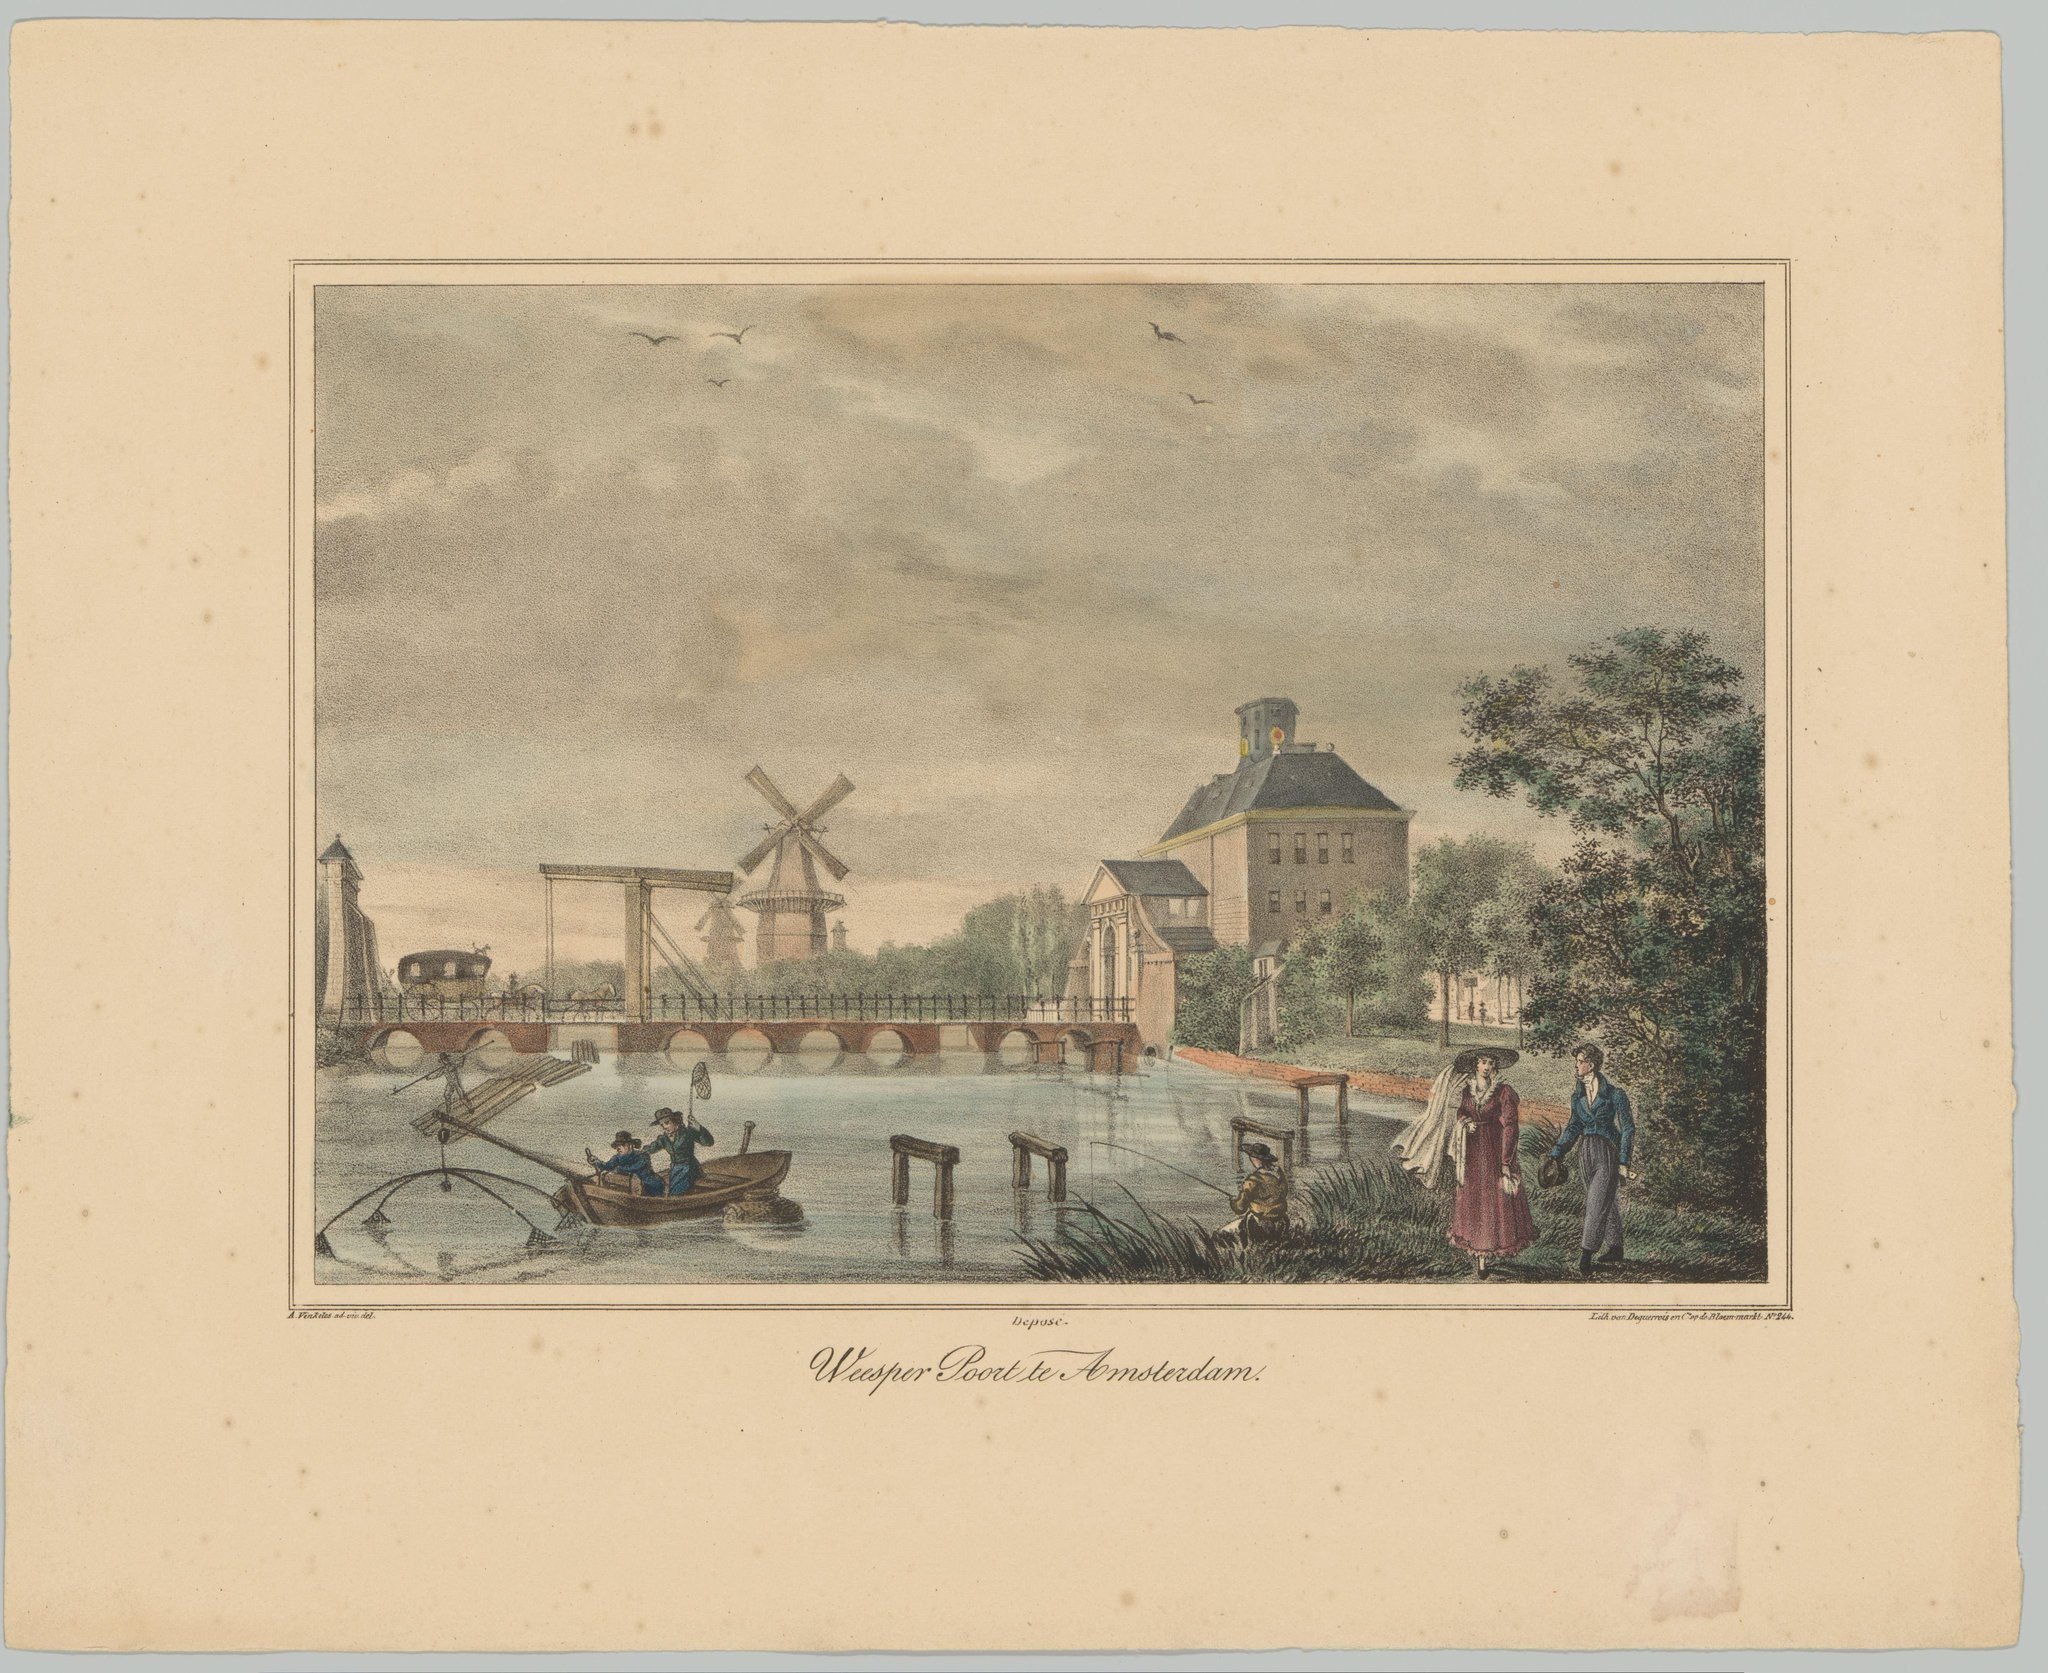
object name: print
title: Gezicht op de Weesperpoort te Amsterdam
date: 1828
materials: paper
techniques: hand coloring, lithograph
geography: amsterdam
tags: gate, entrance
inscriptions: collector's mark: Lugt 2228, : ‘Déposé.’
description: Onderdeel van een omslag met een serie van zes lithografieën van Amsterdamse poorten.